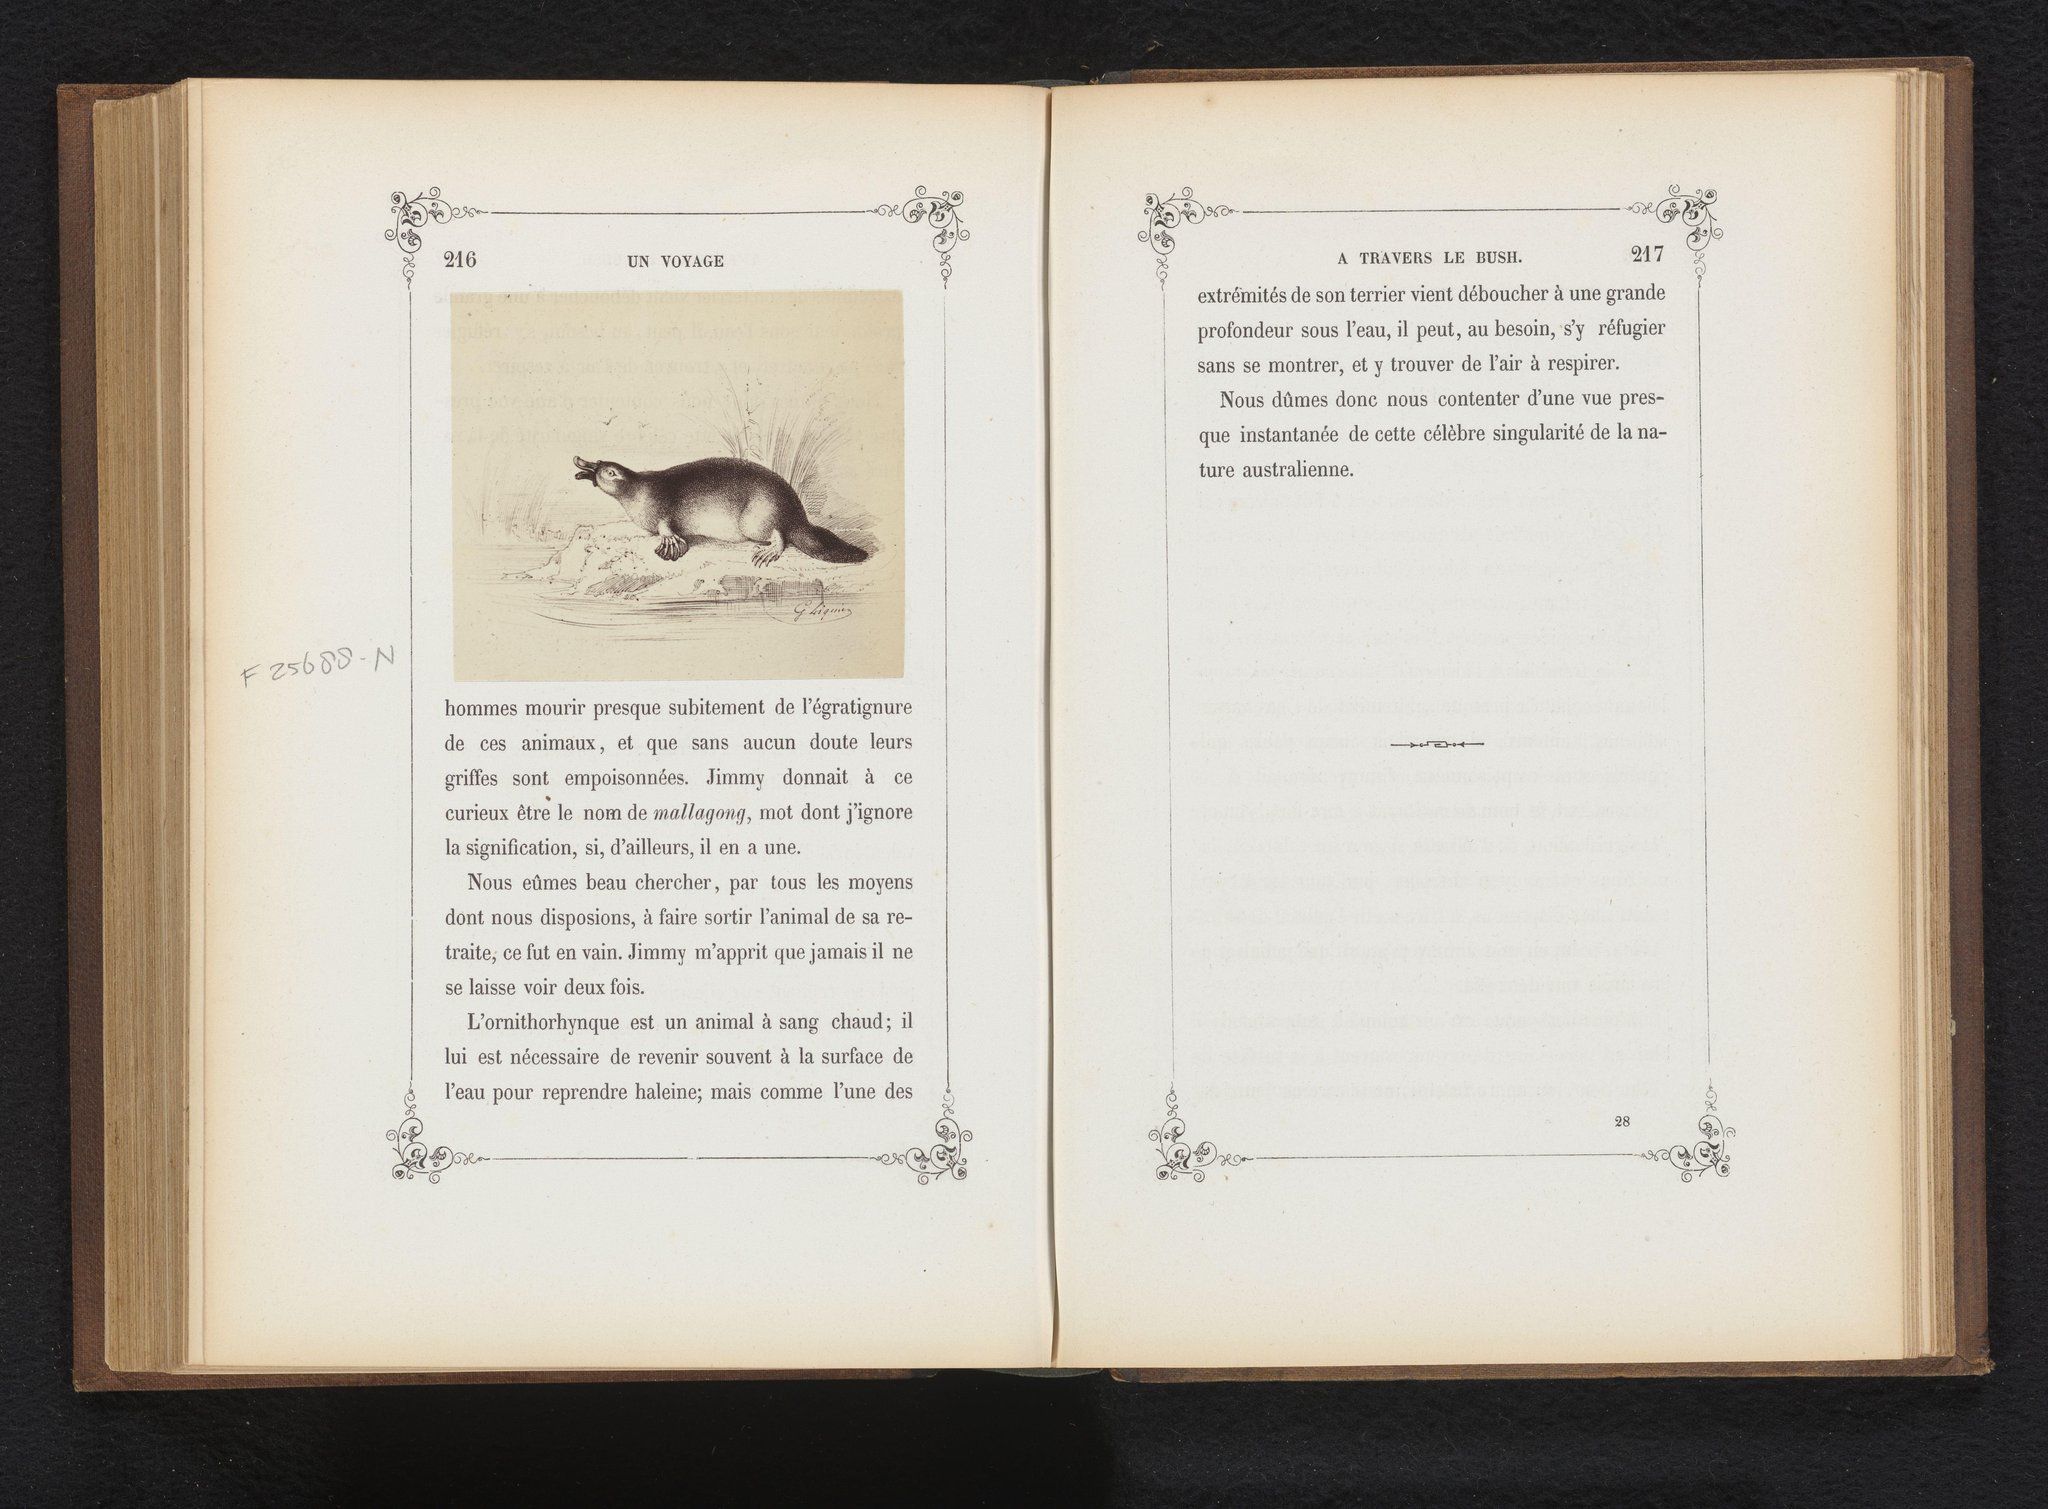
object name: reproduction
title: Fotoreproductie van een tekening van een vogelbekdier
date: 1863-1868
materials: paper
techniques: albumen print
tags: other mammals